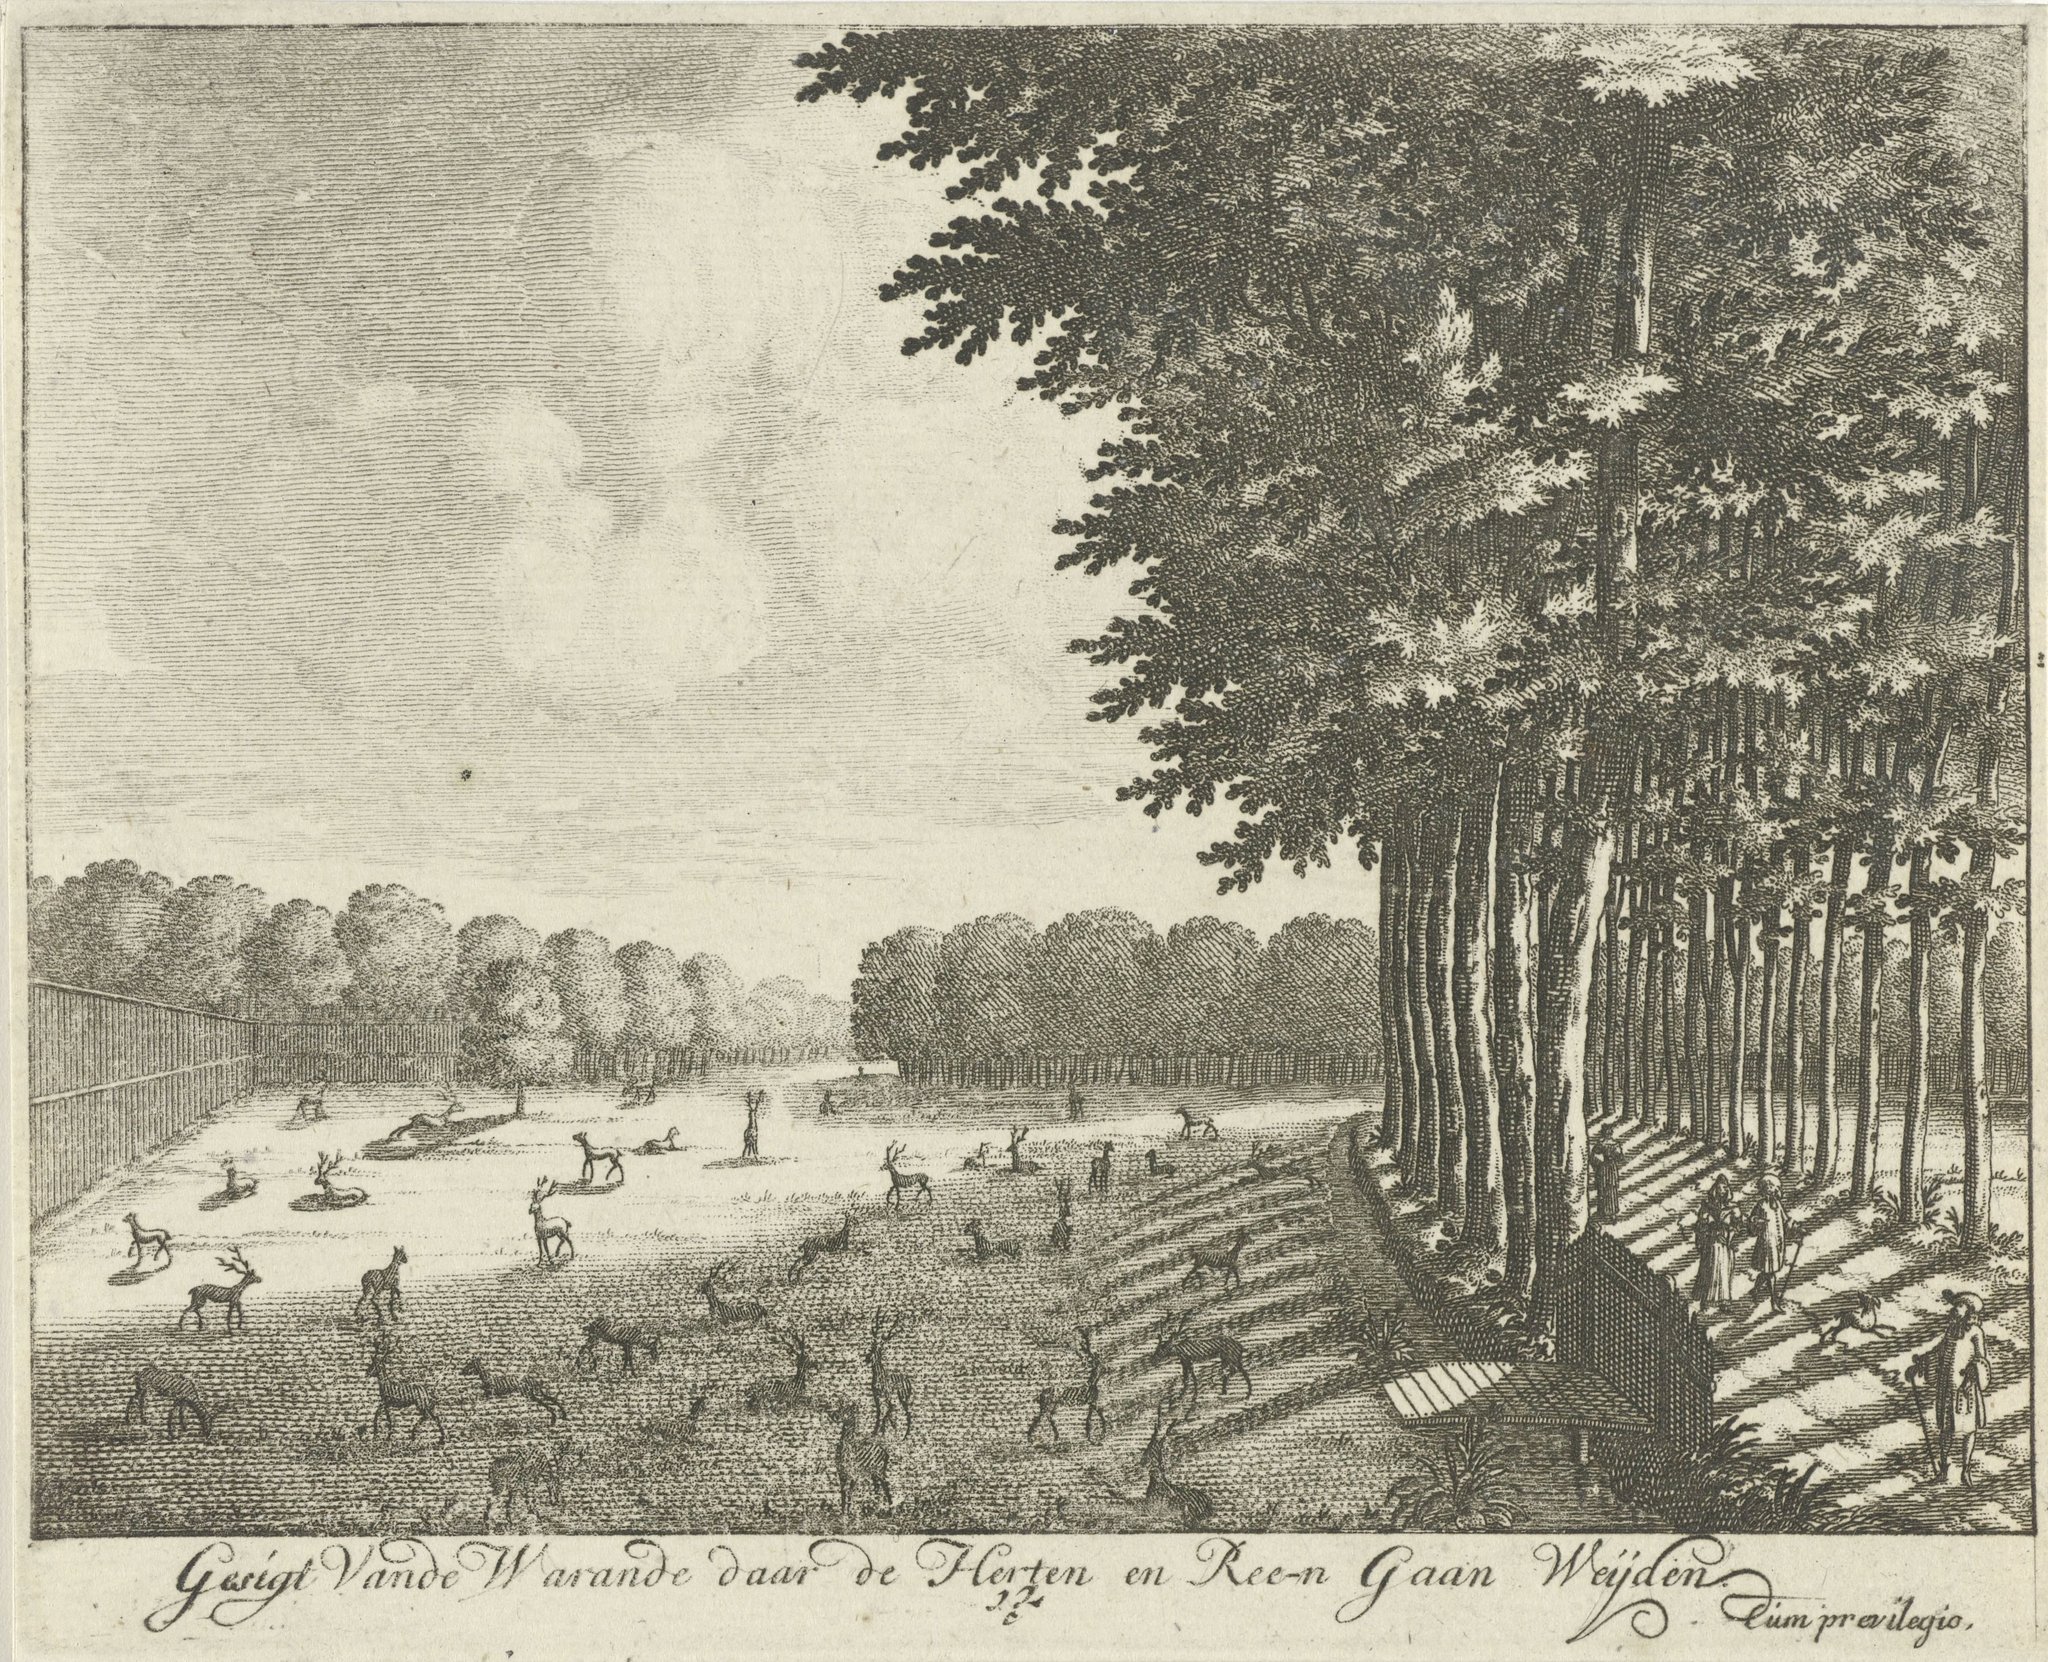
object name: print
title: Hertenkamp van Paleis Soestdijk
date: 1725-1747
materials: paper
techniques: etching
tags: hoofed animals: deer, meadow, pasture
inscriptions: collector's mark: Lugt 2228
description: Gezicht op het hertenkamp van Paleis Soestdijk. De prent maakt deel uit van een serie met zestien gezichten op Paleis Soestdijk en het bijbehorende landgoed.